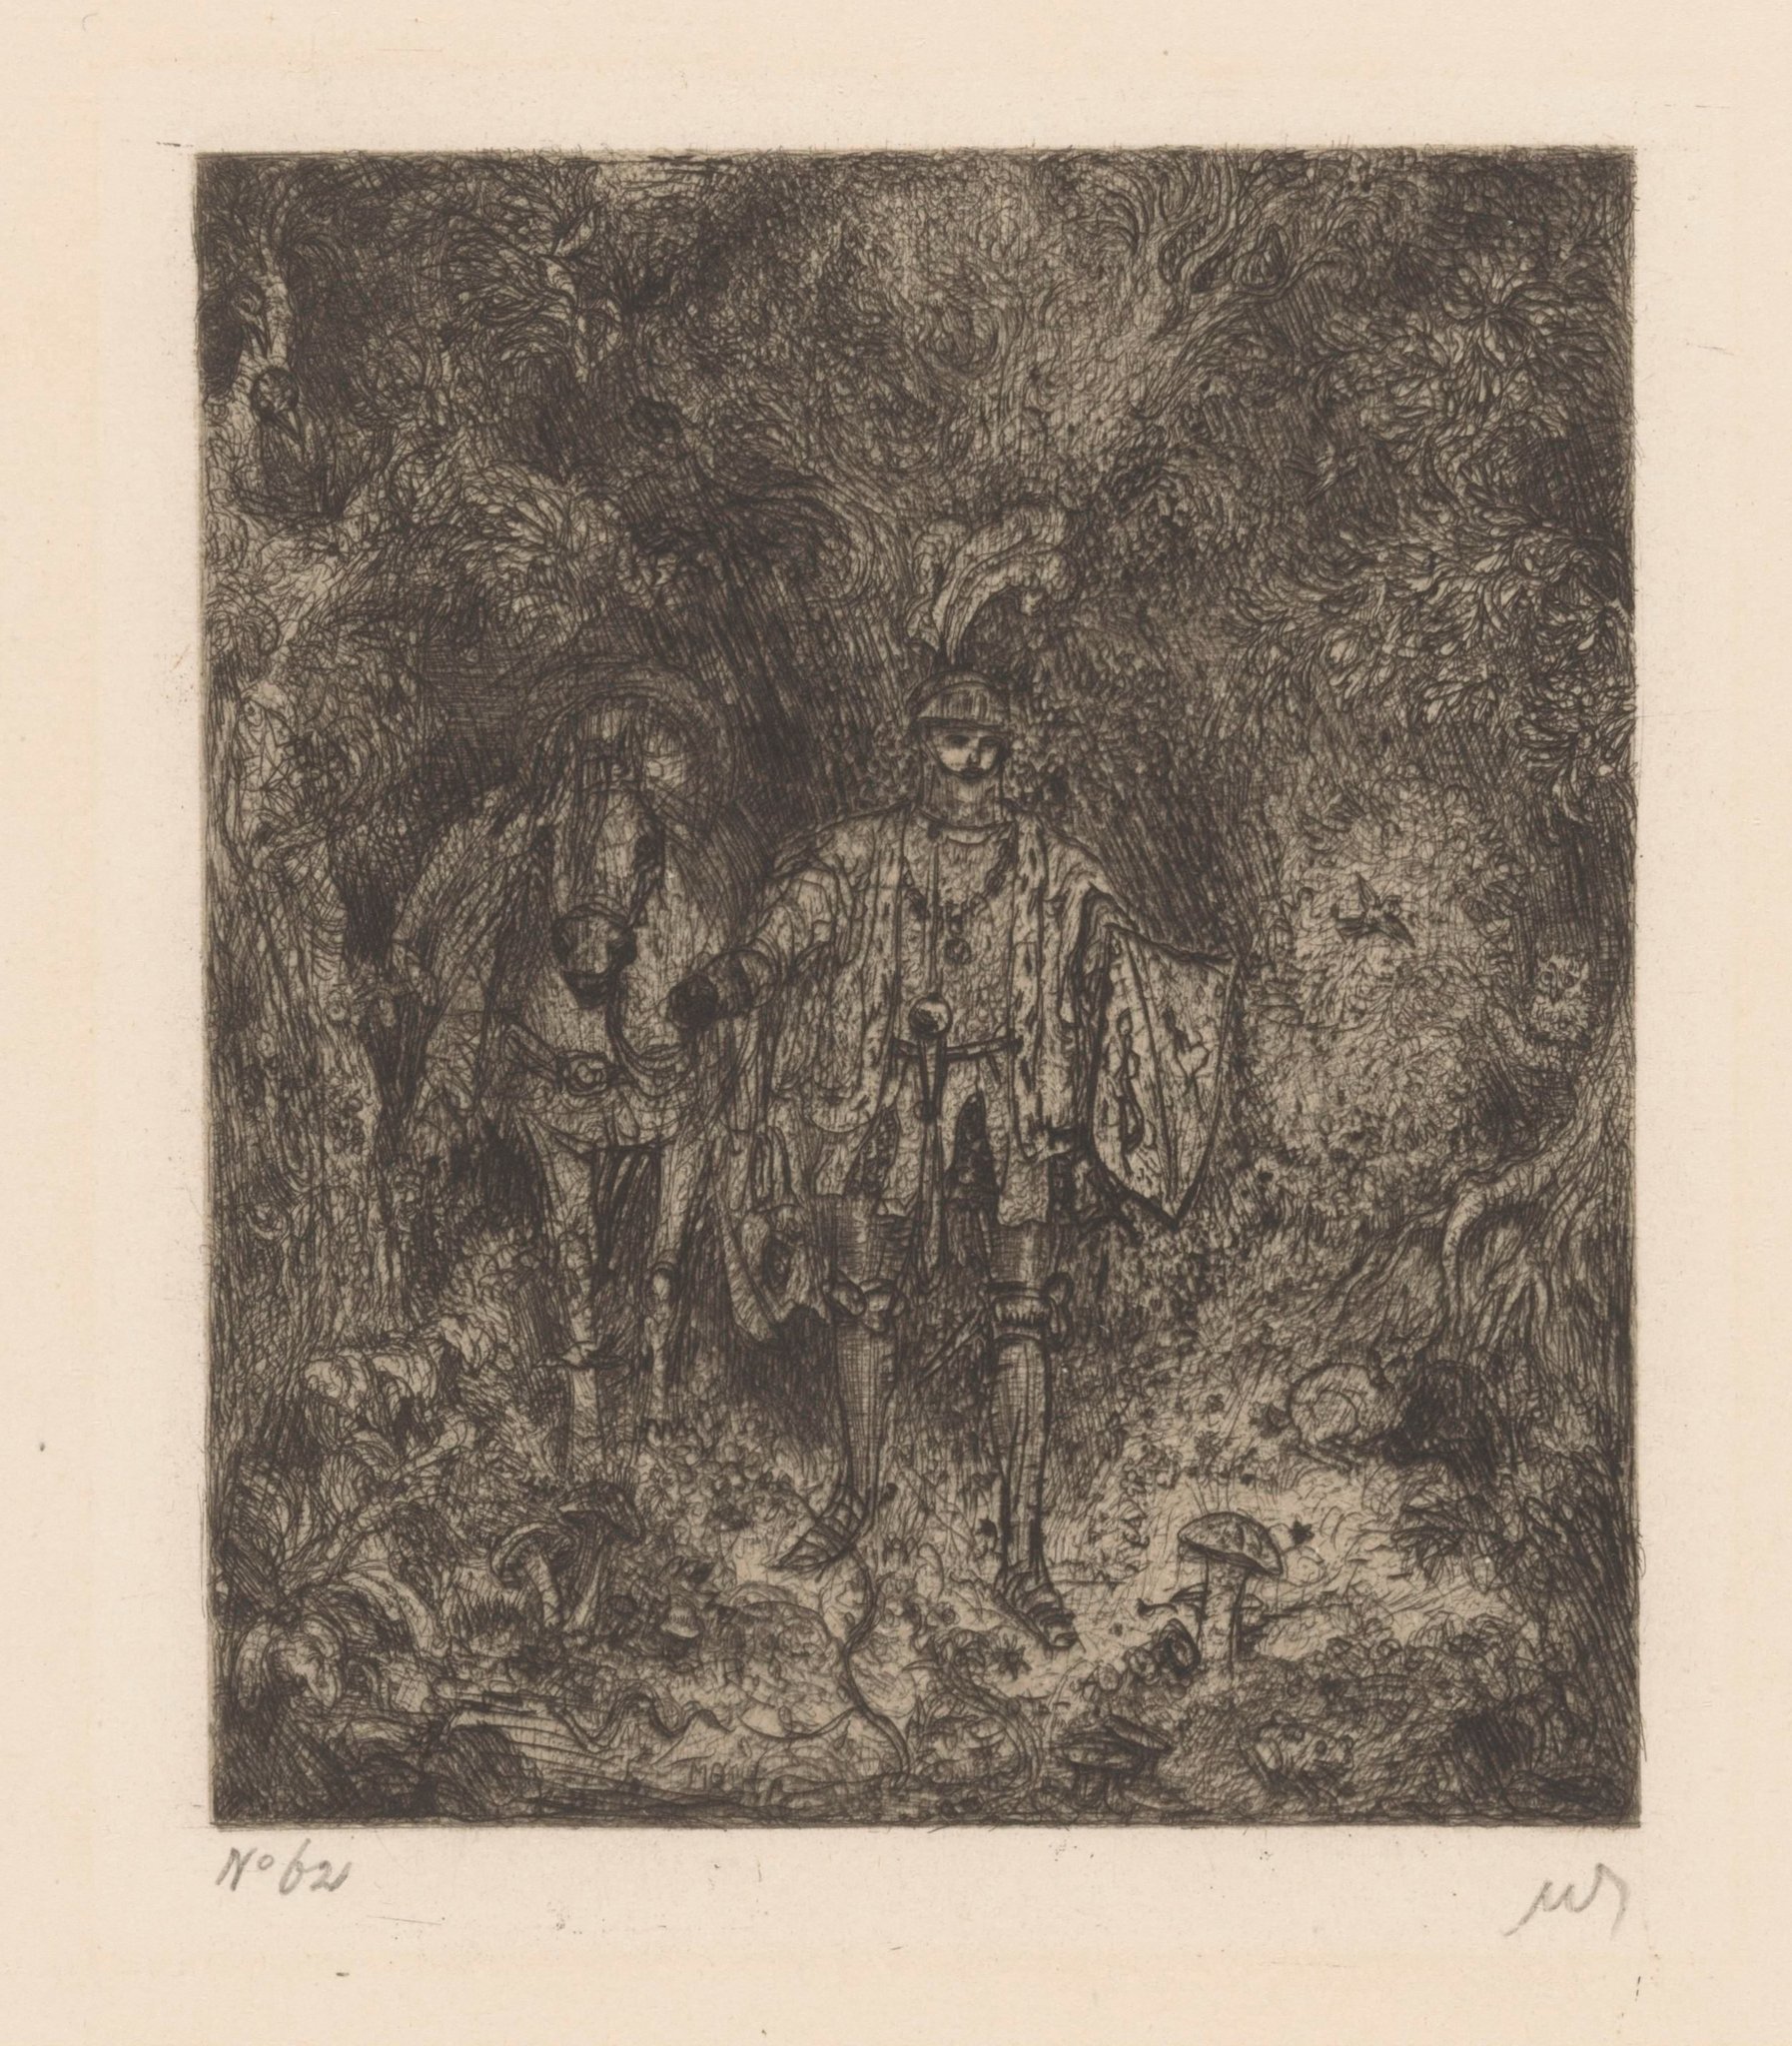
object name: print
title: Toverwoud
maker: marius bauer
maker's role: draughtsman, print maker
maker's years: 1867-1932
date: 1897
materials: paper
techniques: etching, intaglio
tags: riding a horse, ass, or mule; rider, horseman, armour, forest, wood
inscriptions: collector's mark: Lugt 2228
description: Een ruiter in harnas naast een paard in een woud. Linksboven twee vogels. Rechts een uil, een vogel en een konijn. Op de voorgrond een slang, een pad en verschillende paddenstoelen.